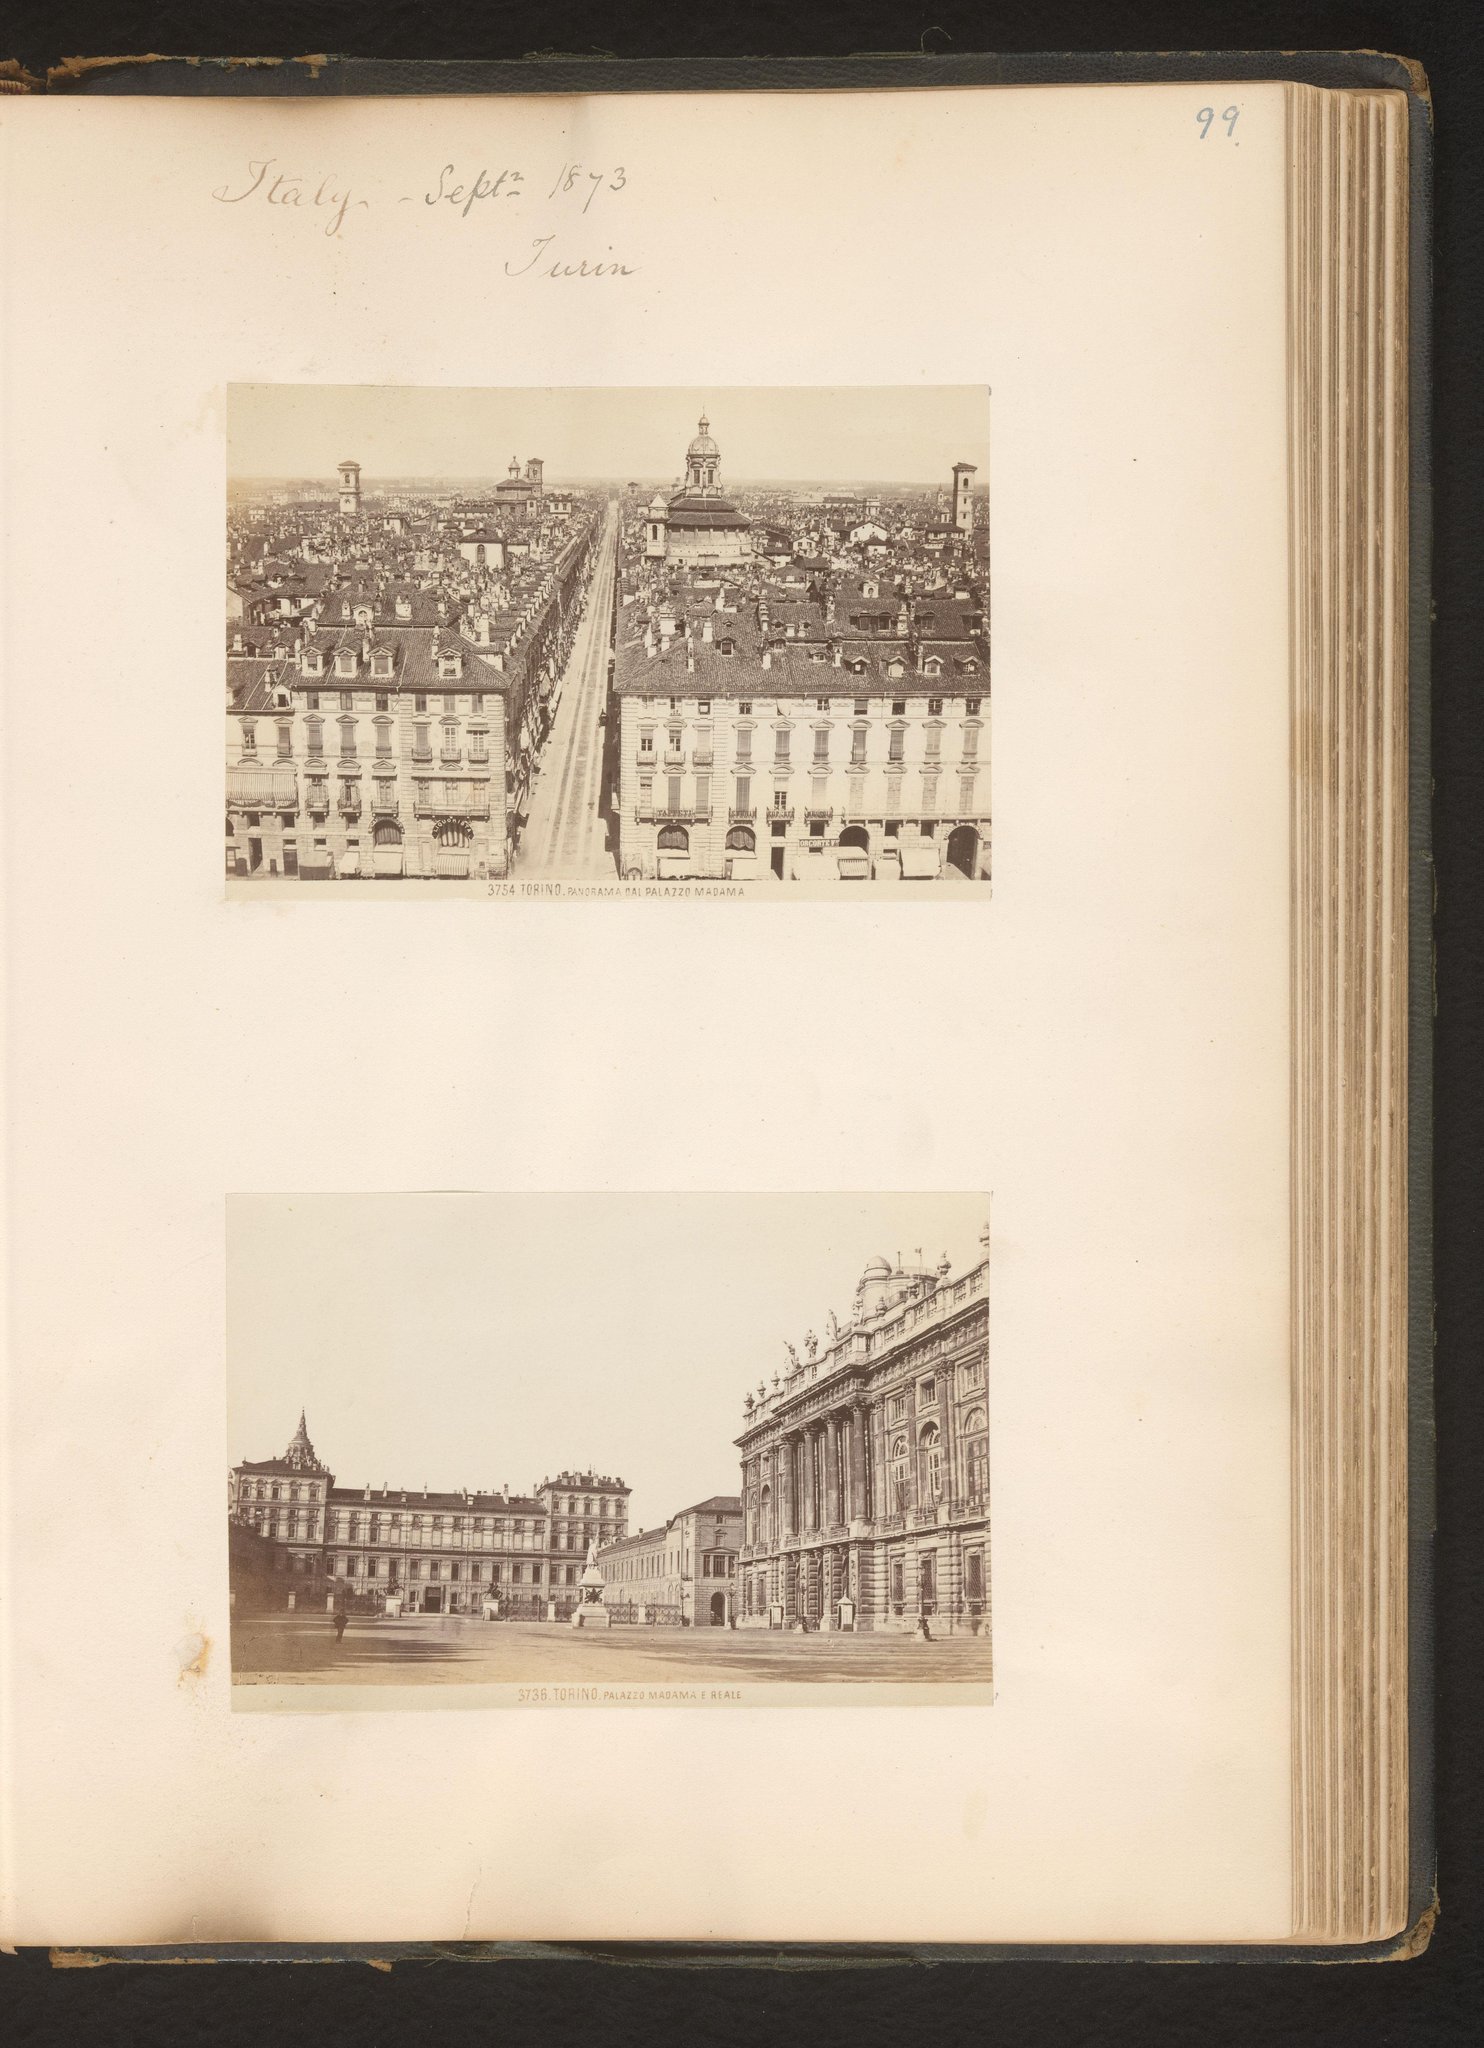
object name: photograph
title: Gebouwen aan Piazza Castello te Turijn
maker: Anonymous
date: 1809-1873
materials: paper, photographic support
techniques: albumen print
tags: palace, street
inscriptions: inscription: ‘3754 Torino. Panorama dal palazzo Madama’, inscription: ‘3736 Torino. Palazzo Madama e reale’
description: Piazza Castello en Palazo Madama te Turijn. Deze pagina maakt deel uit van een album.